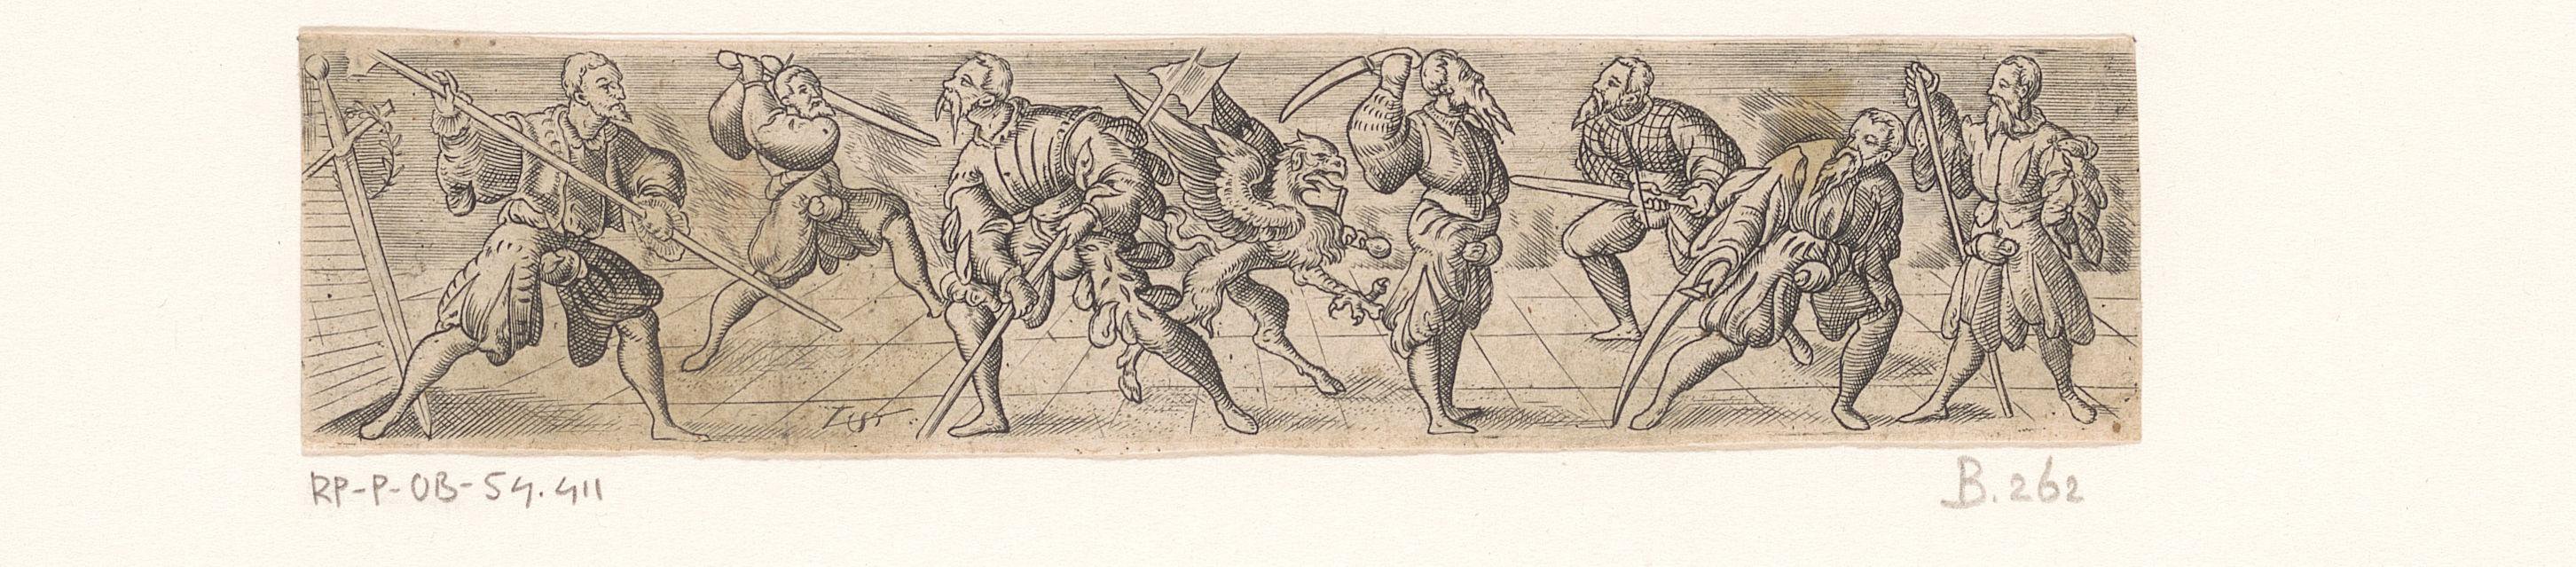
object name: print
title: Griffioen en zeven schermende soldaten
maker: virgilius solis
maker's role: draughtsman, print maker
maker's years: 1514-1562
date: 1524-1562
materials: paper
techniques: engraving, intaglio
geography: nuremberg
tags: griffin (lion/eagle); 'griffo' (ripa), the soldier; the soldier's life, fencing (sport)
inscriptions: collector's mark: Lugt 2228, number: ‘37’